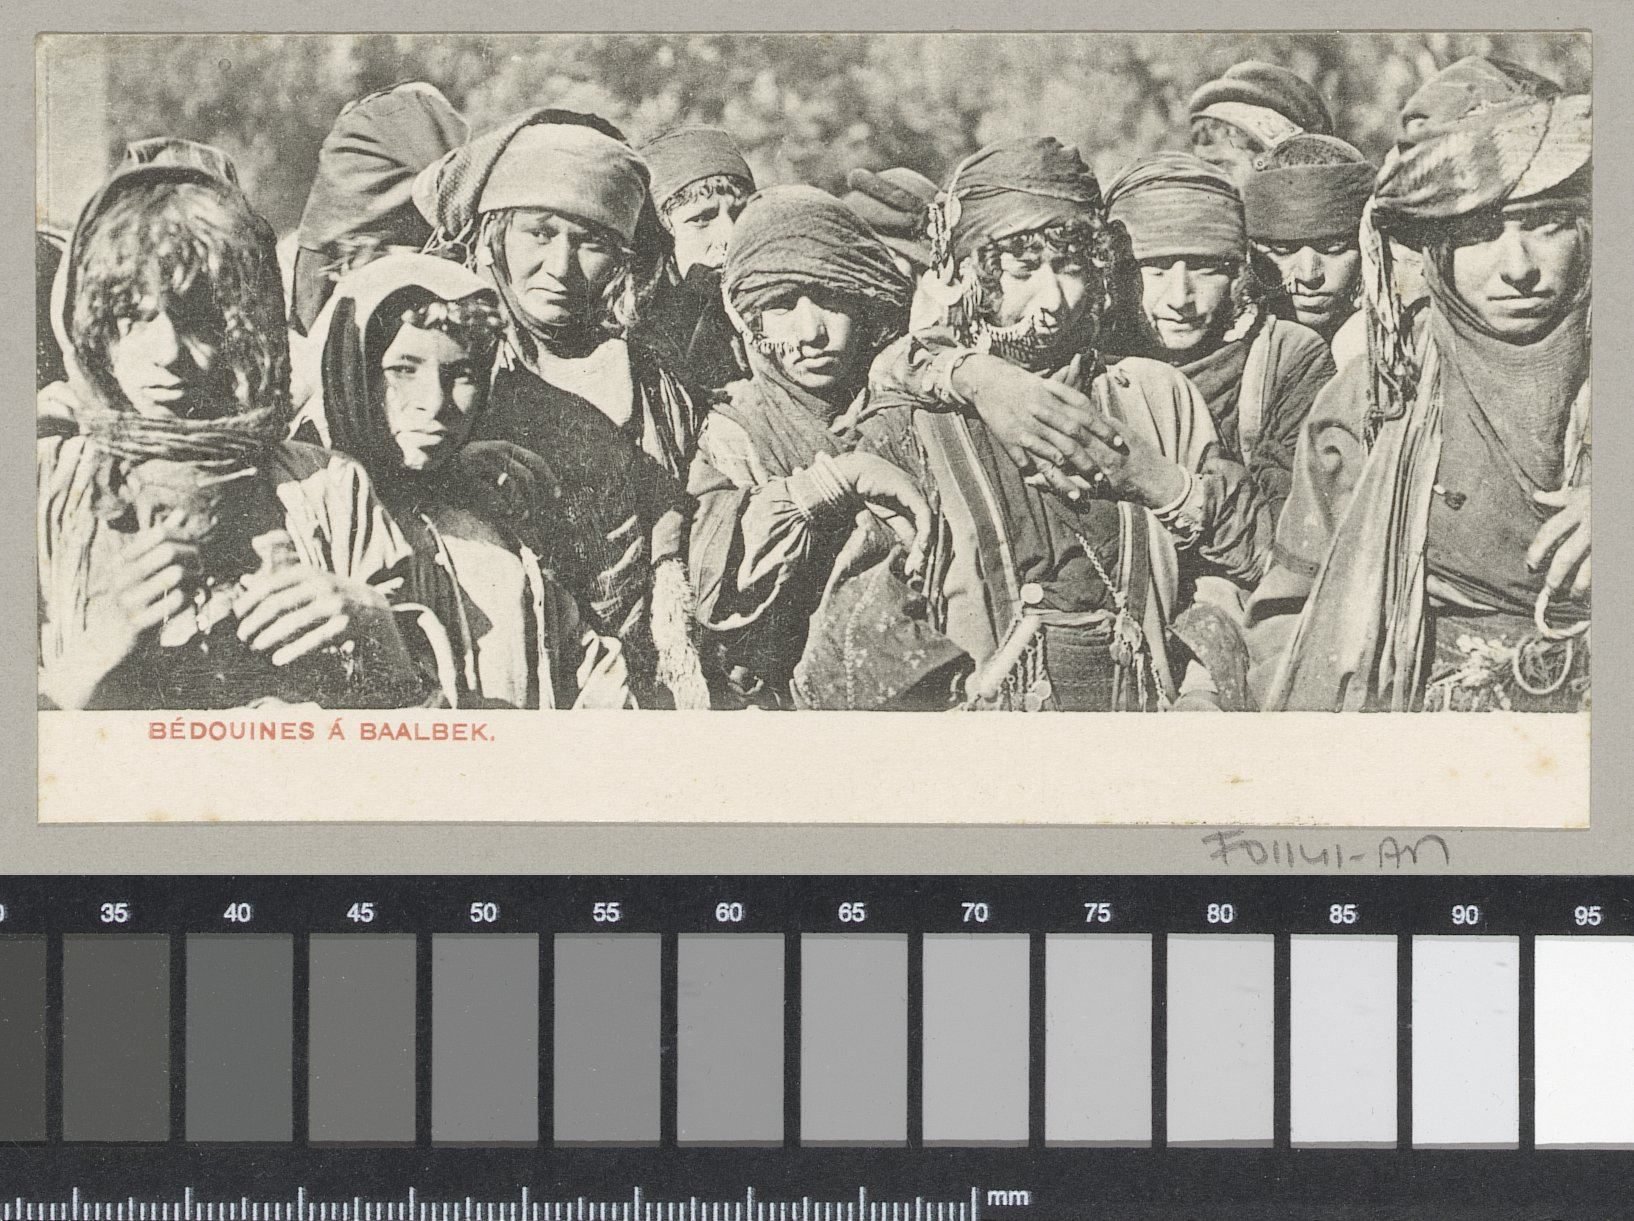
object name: photomechanical print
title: Bédouines á Baalbek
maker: Anonymous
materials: paper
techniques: photograph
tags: adult woman, head-gear (with name)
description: Onderdeel van Fotoalbum van een reis door Zuid-Europa en het Midden-Oosten.